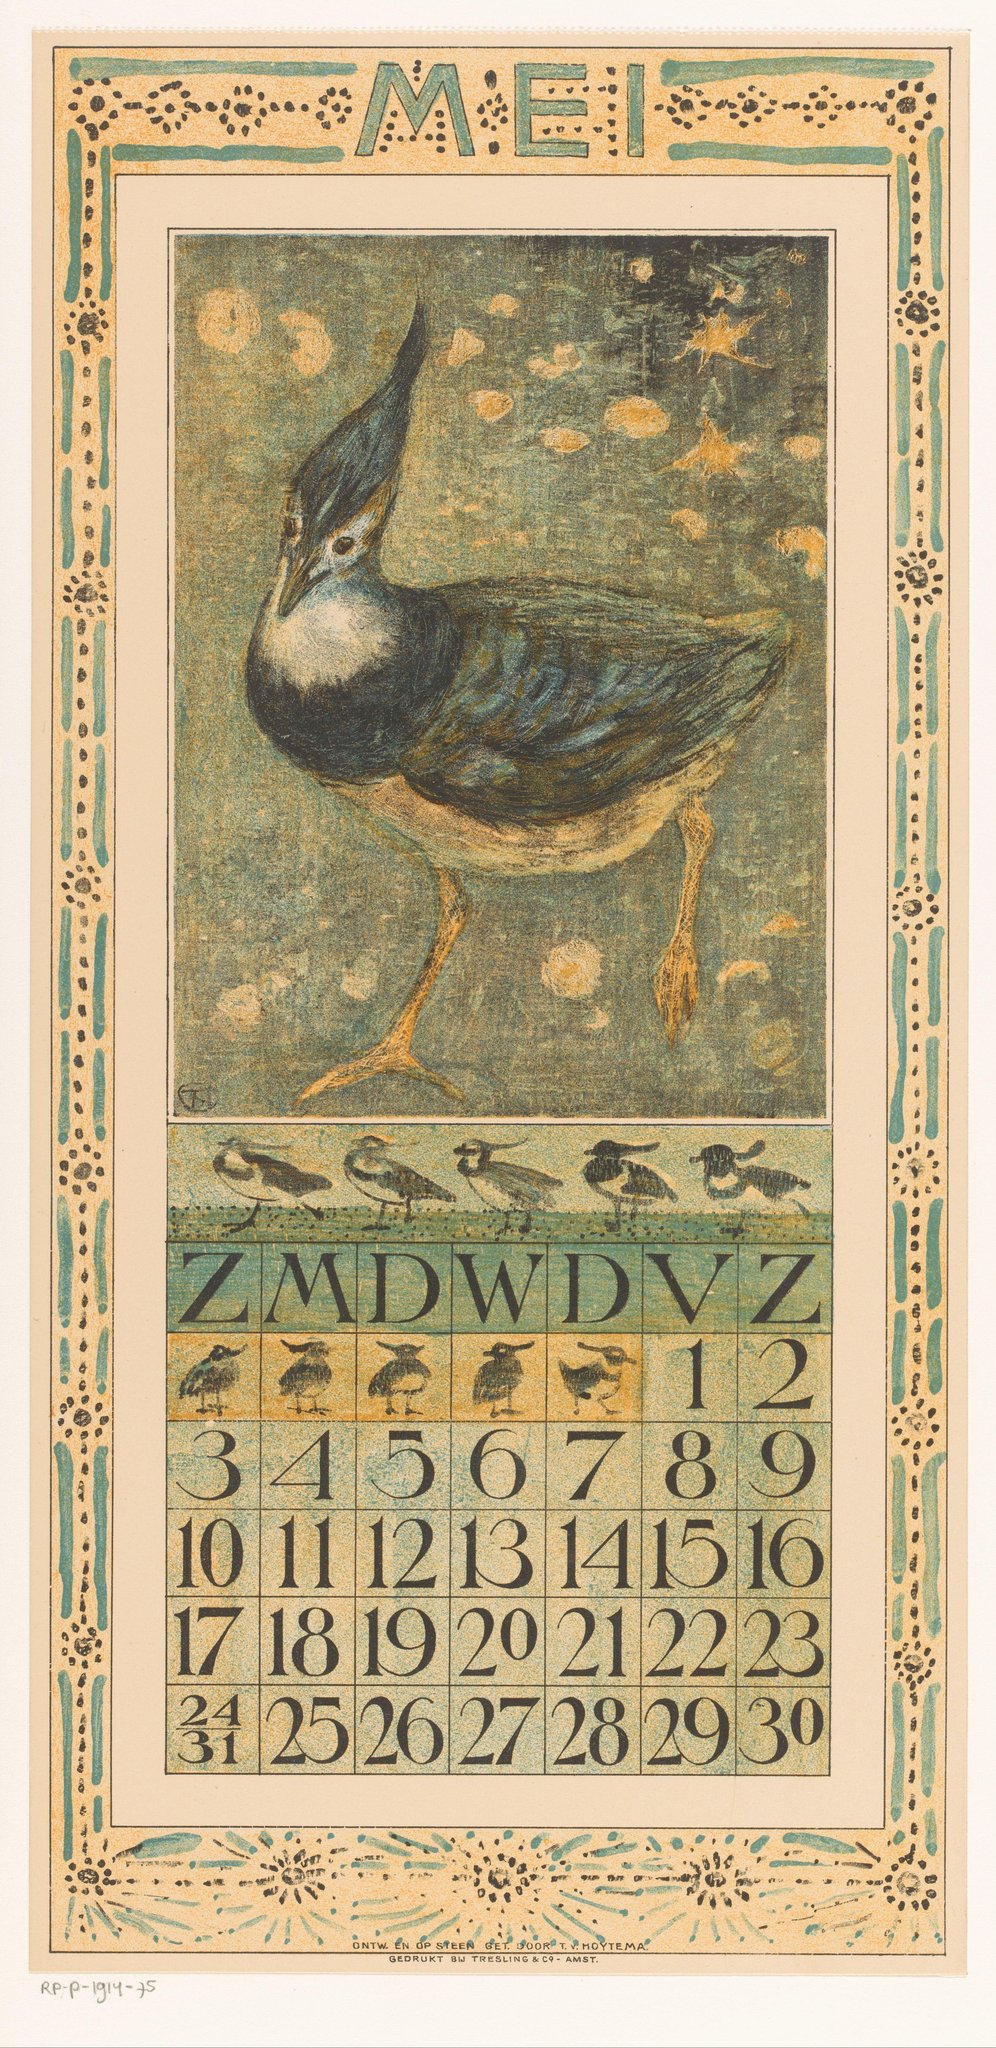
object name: print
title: Kalender 1908 12 lithografien door Th. v. Hoytema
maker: theo van hoytema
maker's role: draughtsman, painter, print maker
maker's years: 1863-1917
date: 1907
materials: paper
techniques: lithograph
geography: amsterdam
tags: shore-birds and wading-birds: lapwing, may ~ other concepts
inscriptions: collector's mark: Lugt 2228